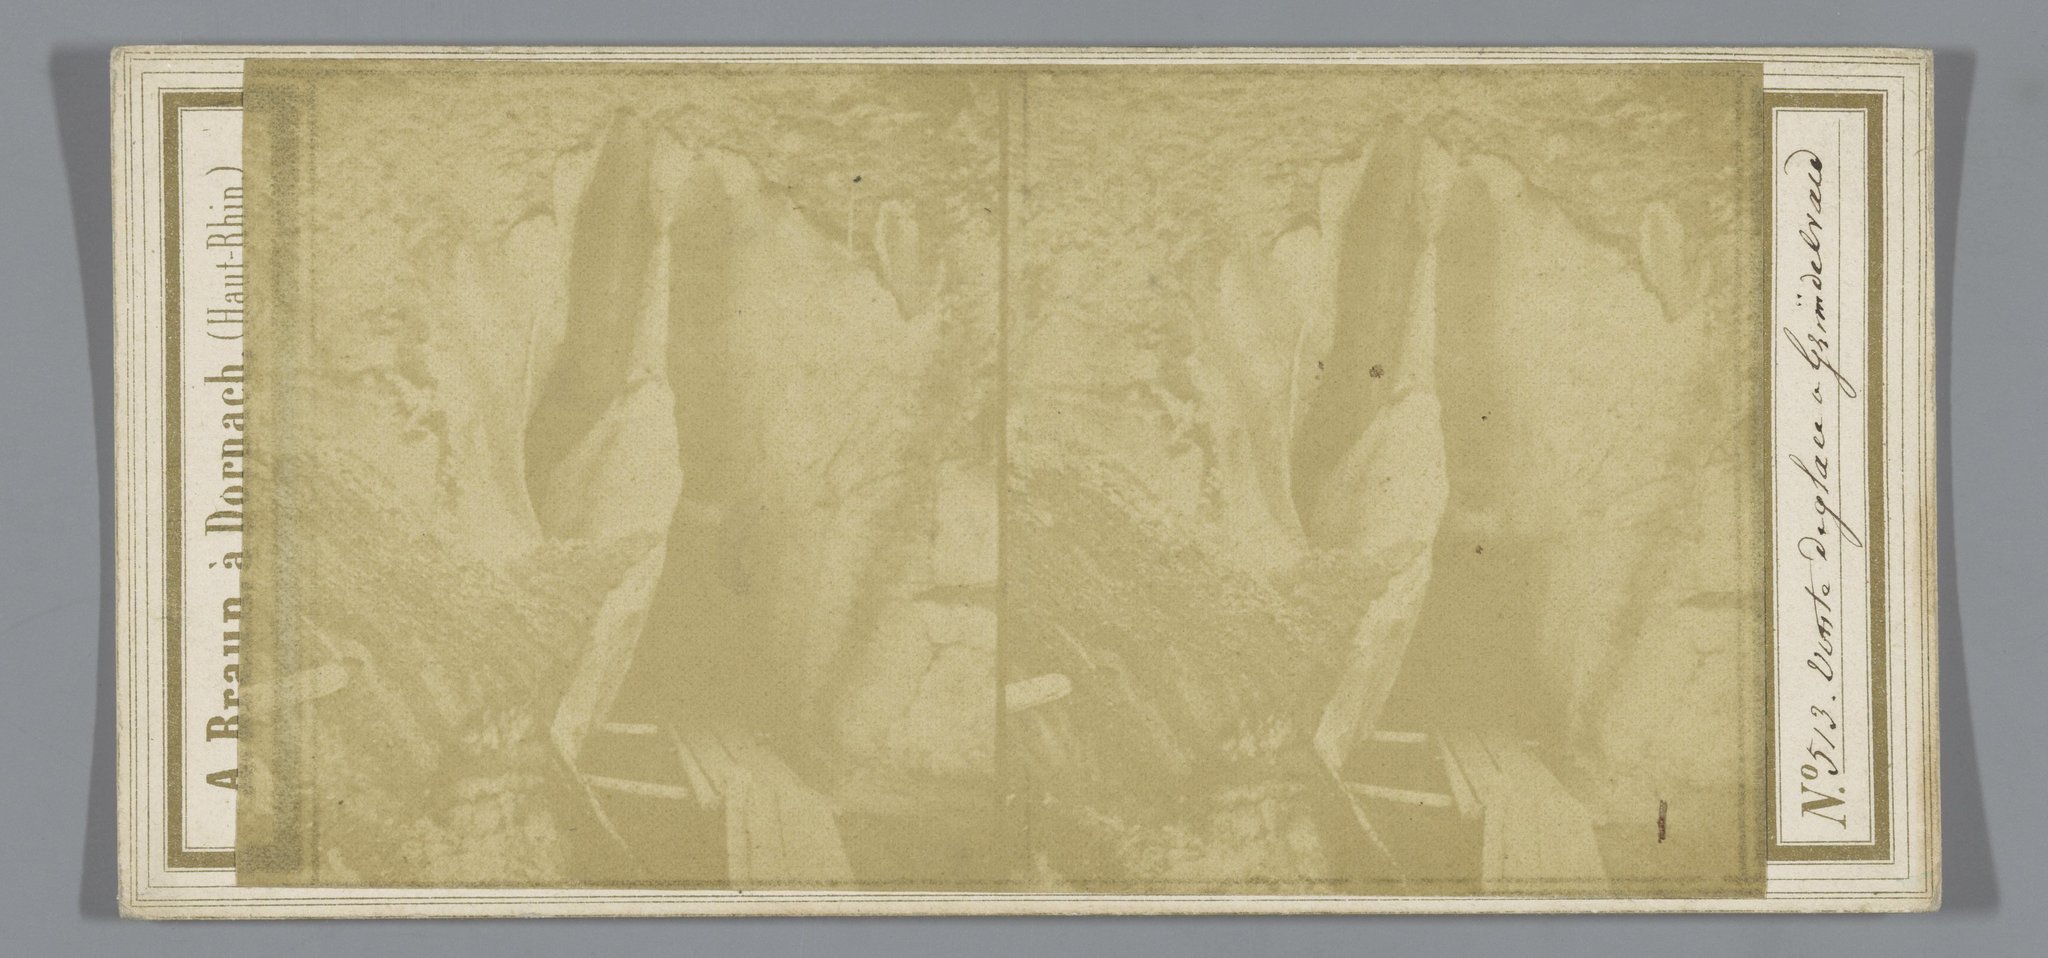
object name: stereograph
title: Gletsjerkloof, mogelijk de Lage Grindelwaldgletsjer langs de Eiger nabij Grindelwald, Zwitserland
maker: Anonymous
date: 1860-1866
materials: cardboard, paper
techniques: albumen print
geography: dornach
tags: glacier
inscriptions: number: ‘No. 513.’